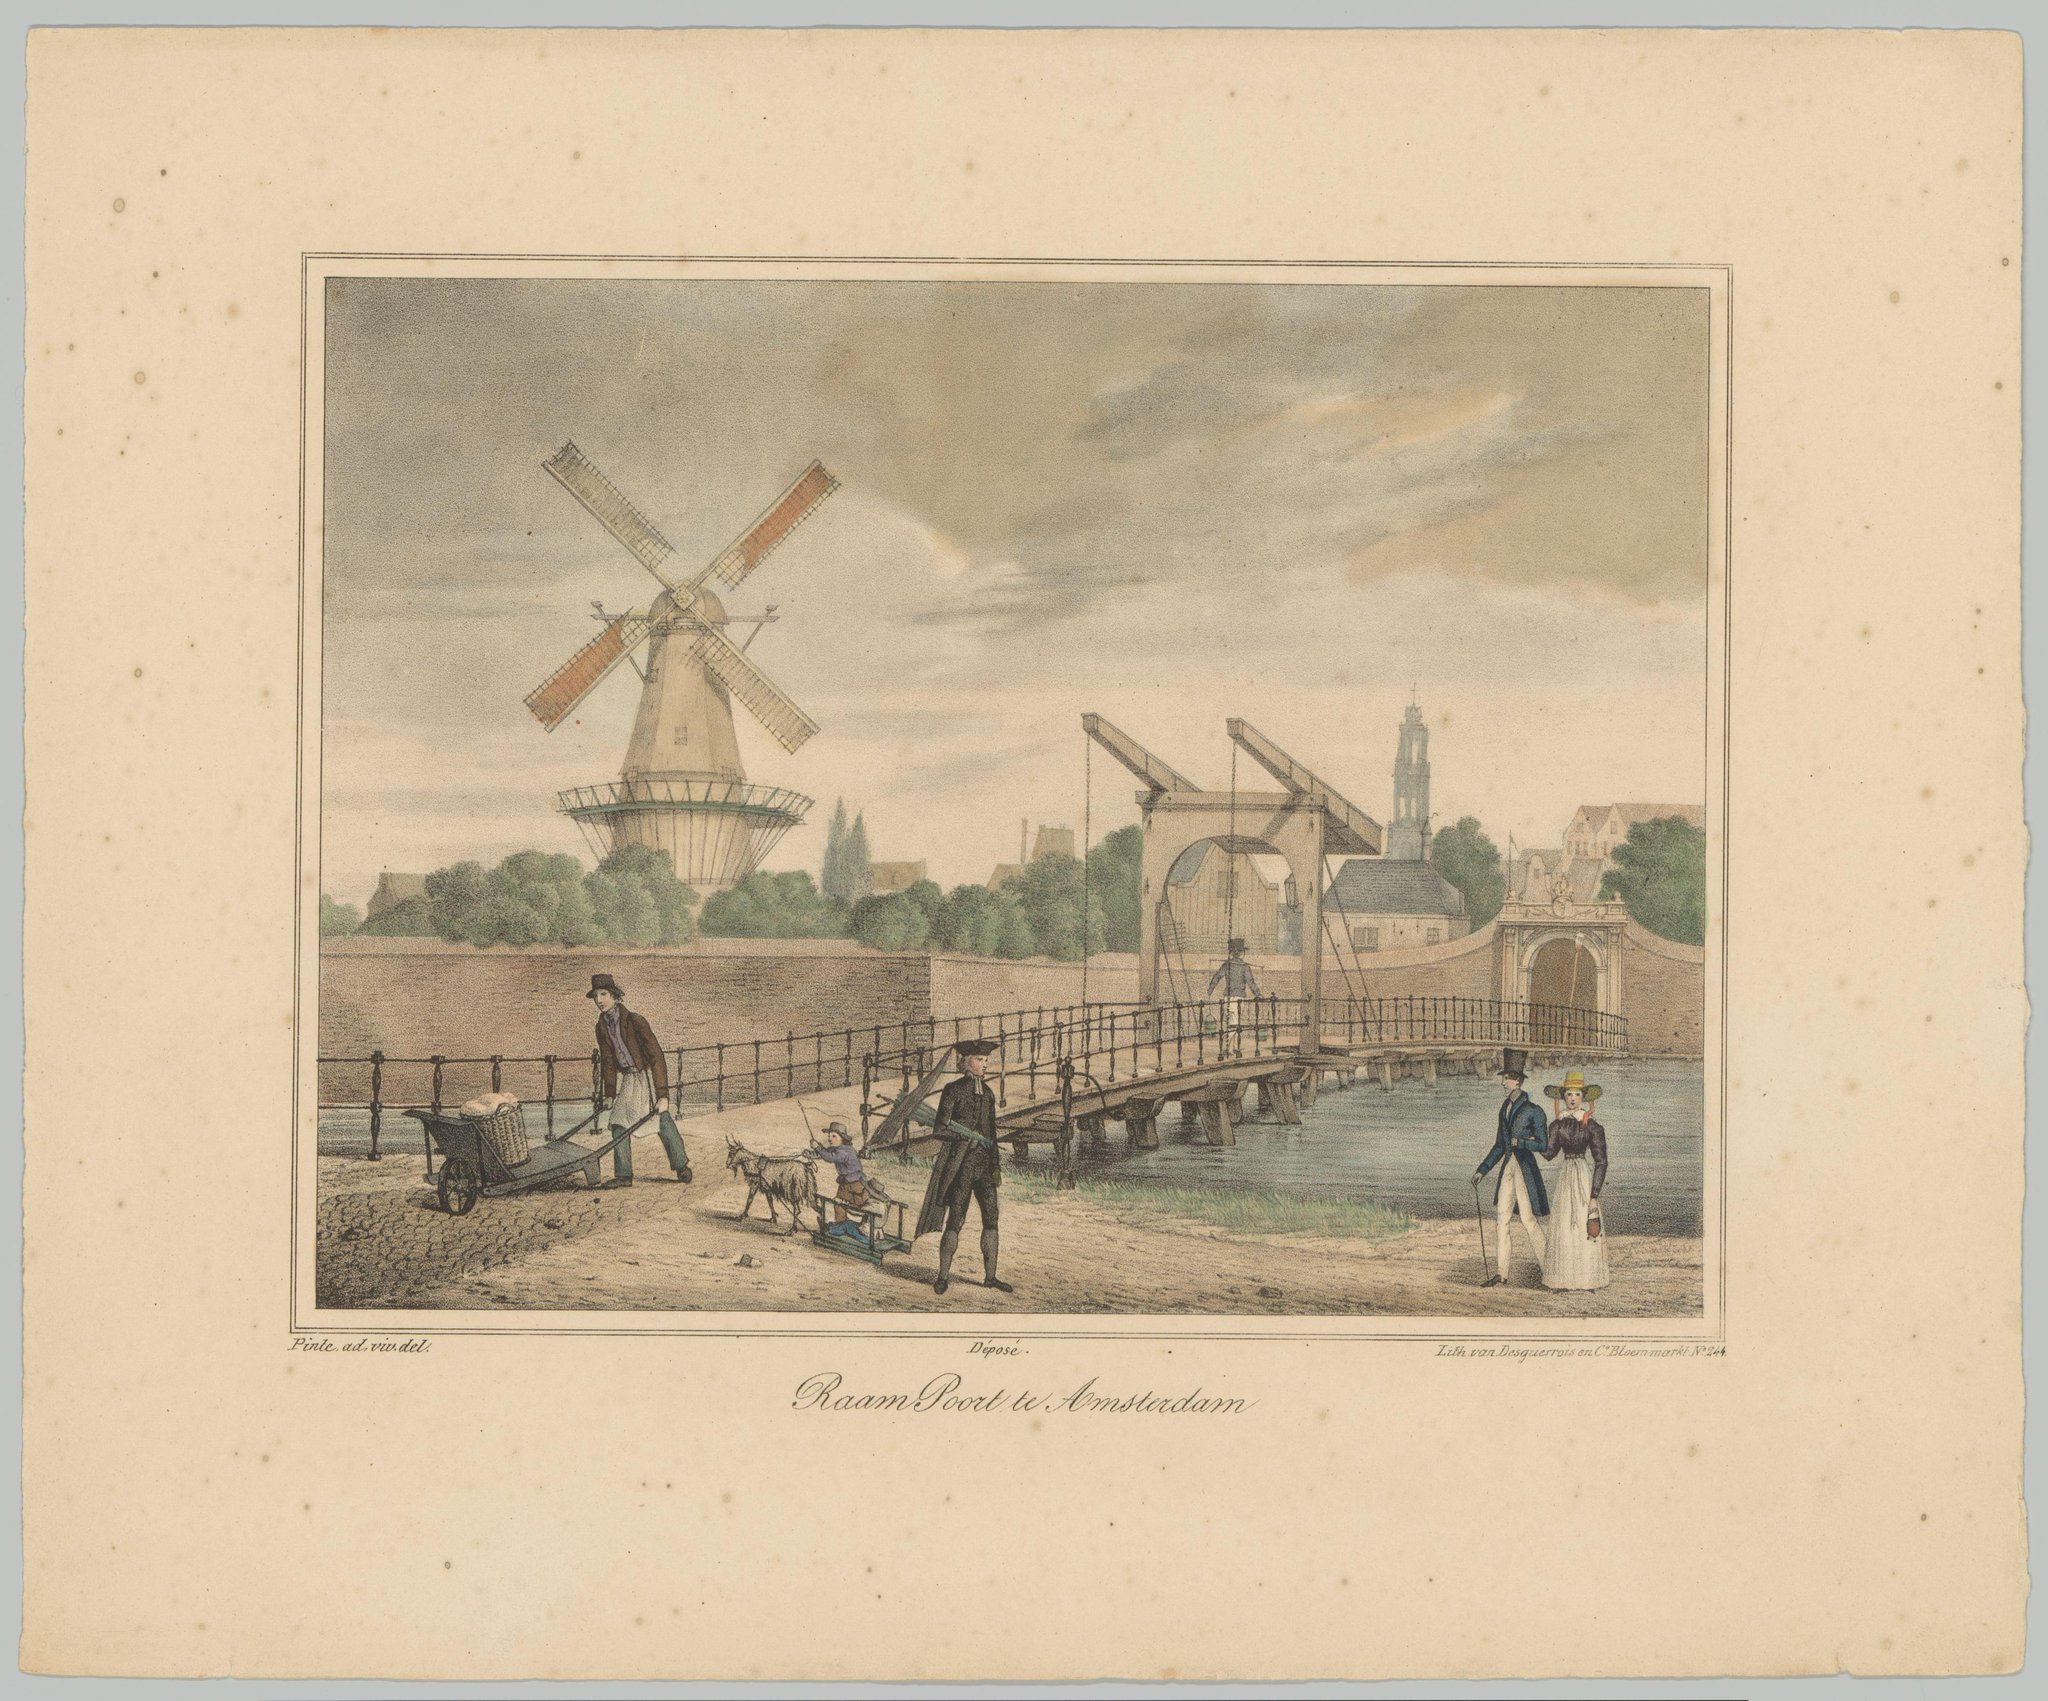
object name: print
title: Gezichten van de Zes Voornaamste Poorten der Stad Amsterdam. 1ste Cahier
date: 1828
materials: paper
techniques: hand coloring, lithograph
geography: amsterdam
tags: gate, entrance, canals, waters (in city) (+ city(-scape) with figures, staffage)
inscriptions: collector's mark: Lugt 2228, : ‘Déposé.’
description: Onderdeel van een omslag met een serie van zes lithografieën van Amsterdamse poorten.